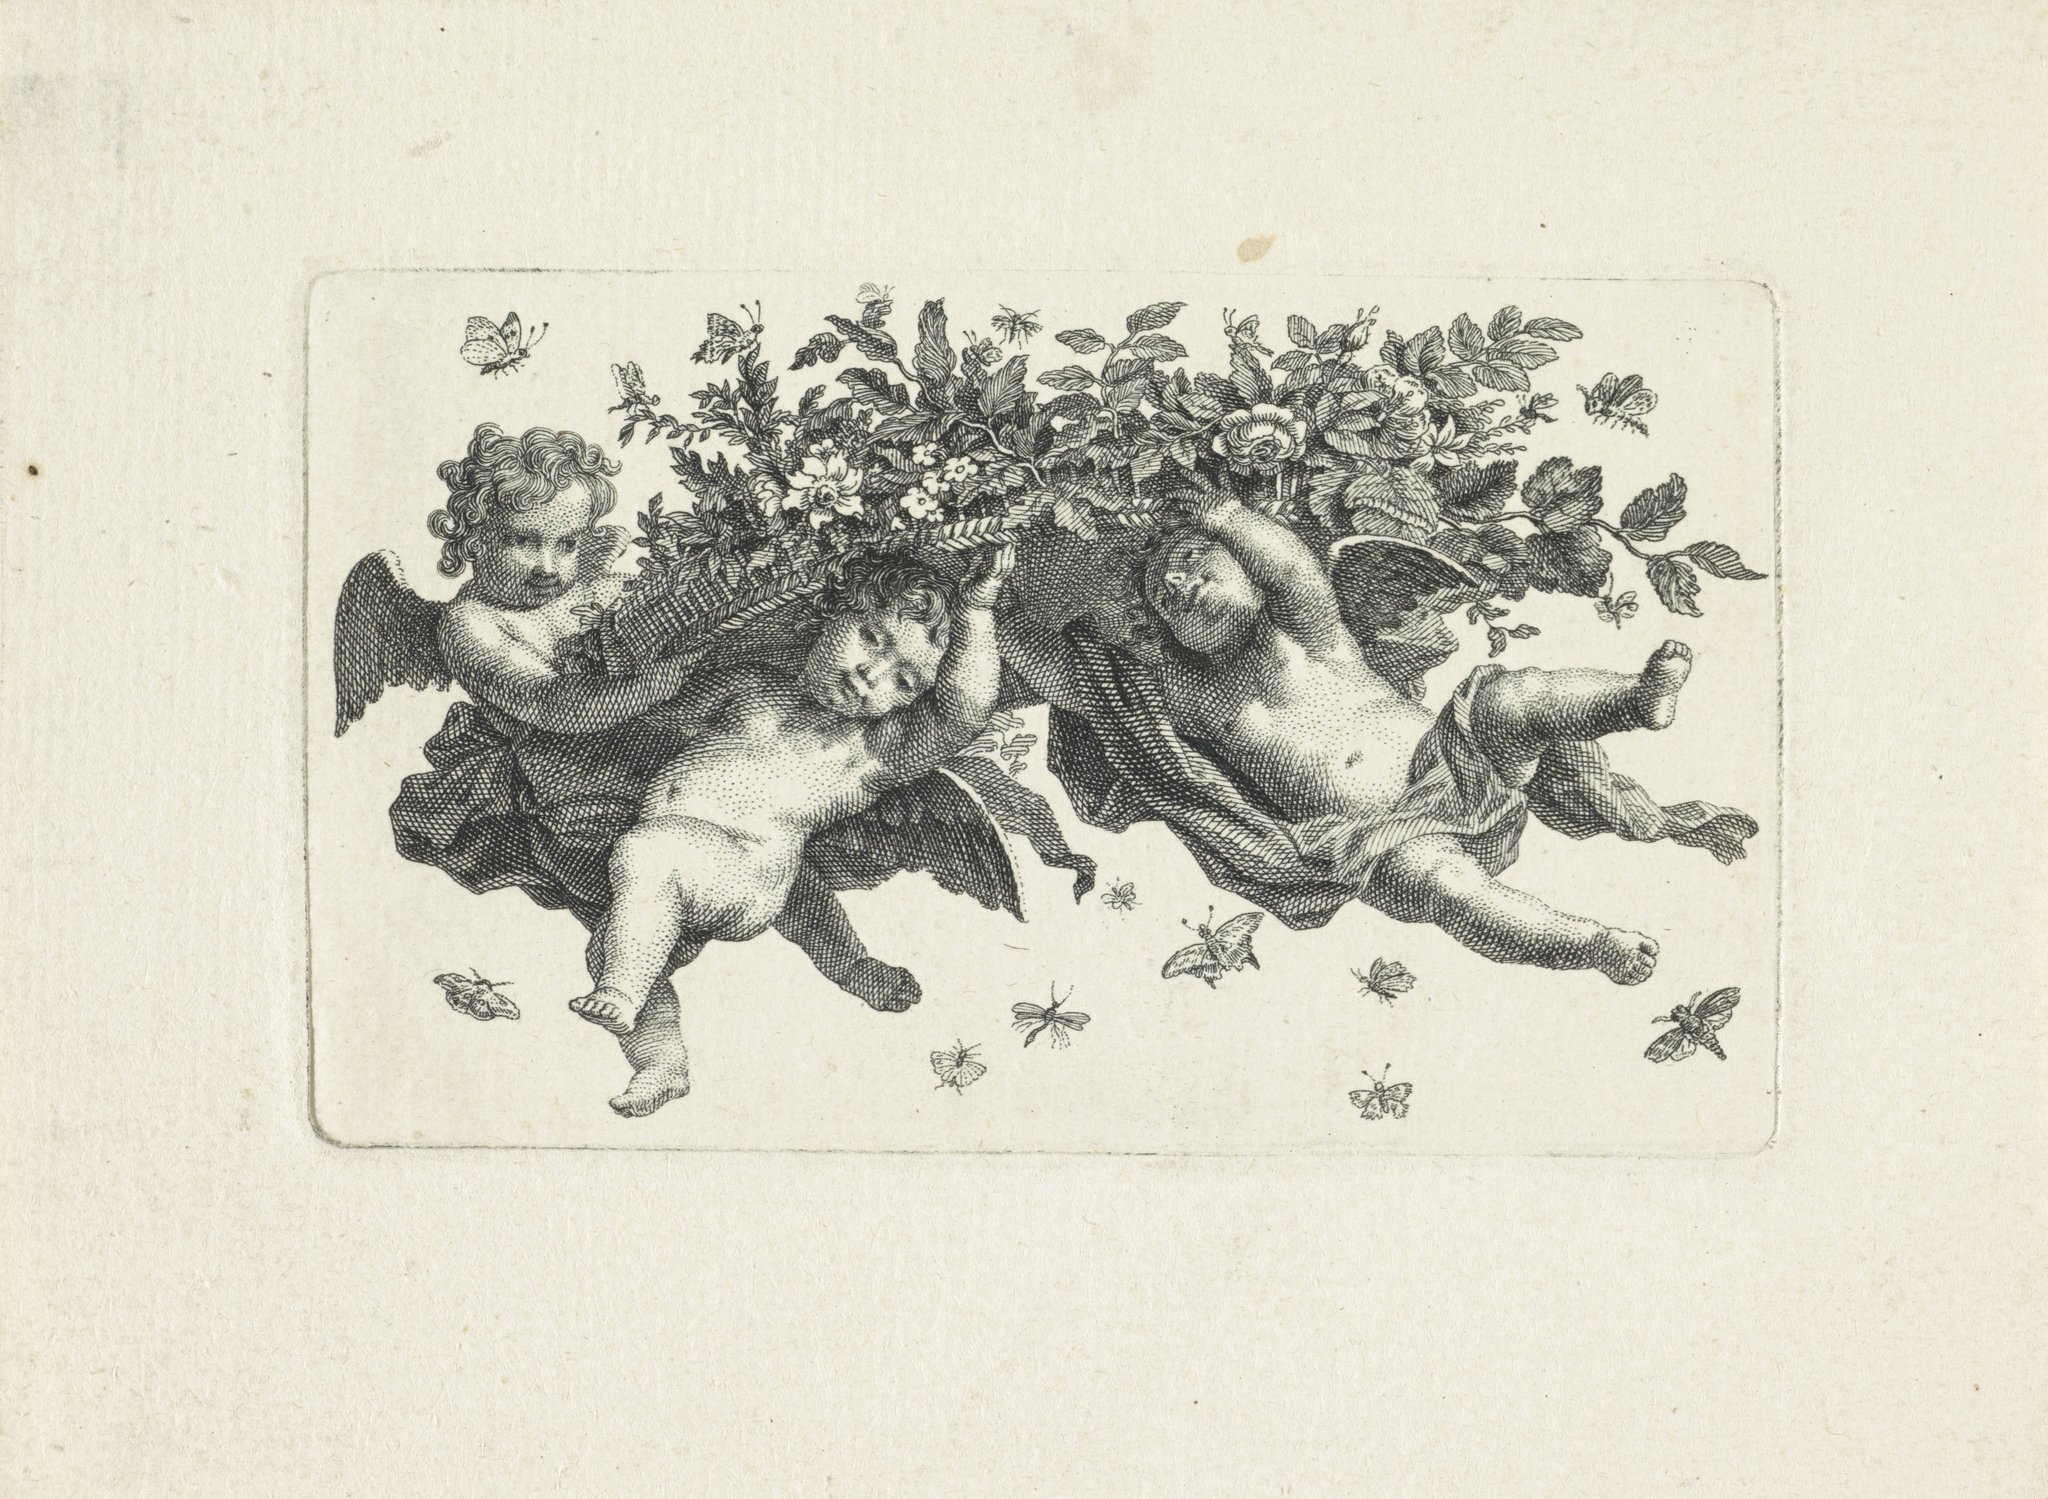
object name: print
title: Drie putti met een bloemenmand en vlinders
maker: jan wandelaar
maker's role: draughtsman, print maker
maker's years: 1690-1759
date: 1750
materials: paper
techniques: engraving, etching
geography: northern netherlands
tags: flowers, container made of plant material other than wood: basket, insects: butterfly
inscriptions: collector's mark: Lugt 240